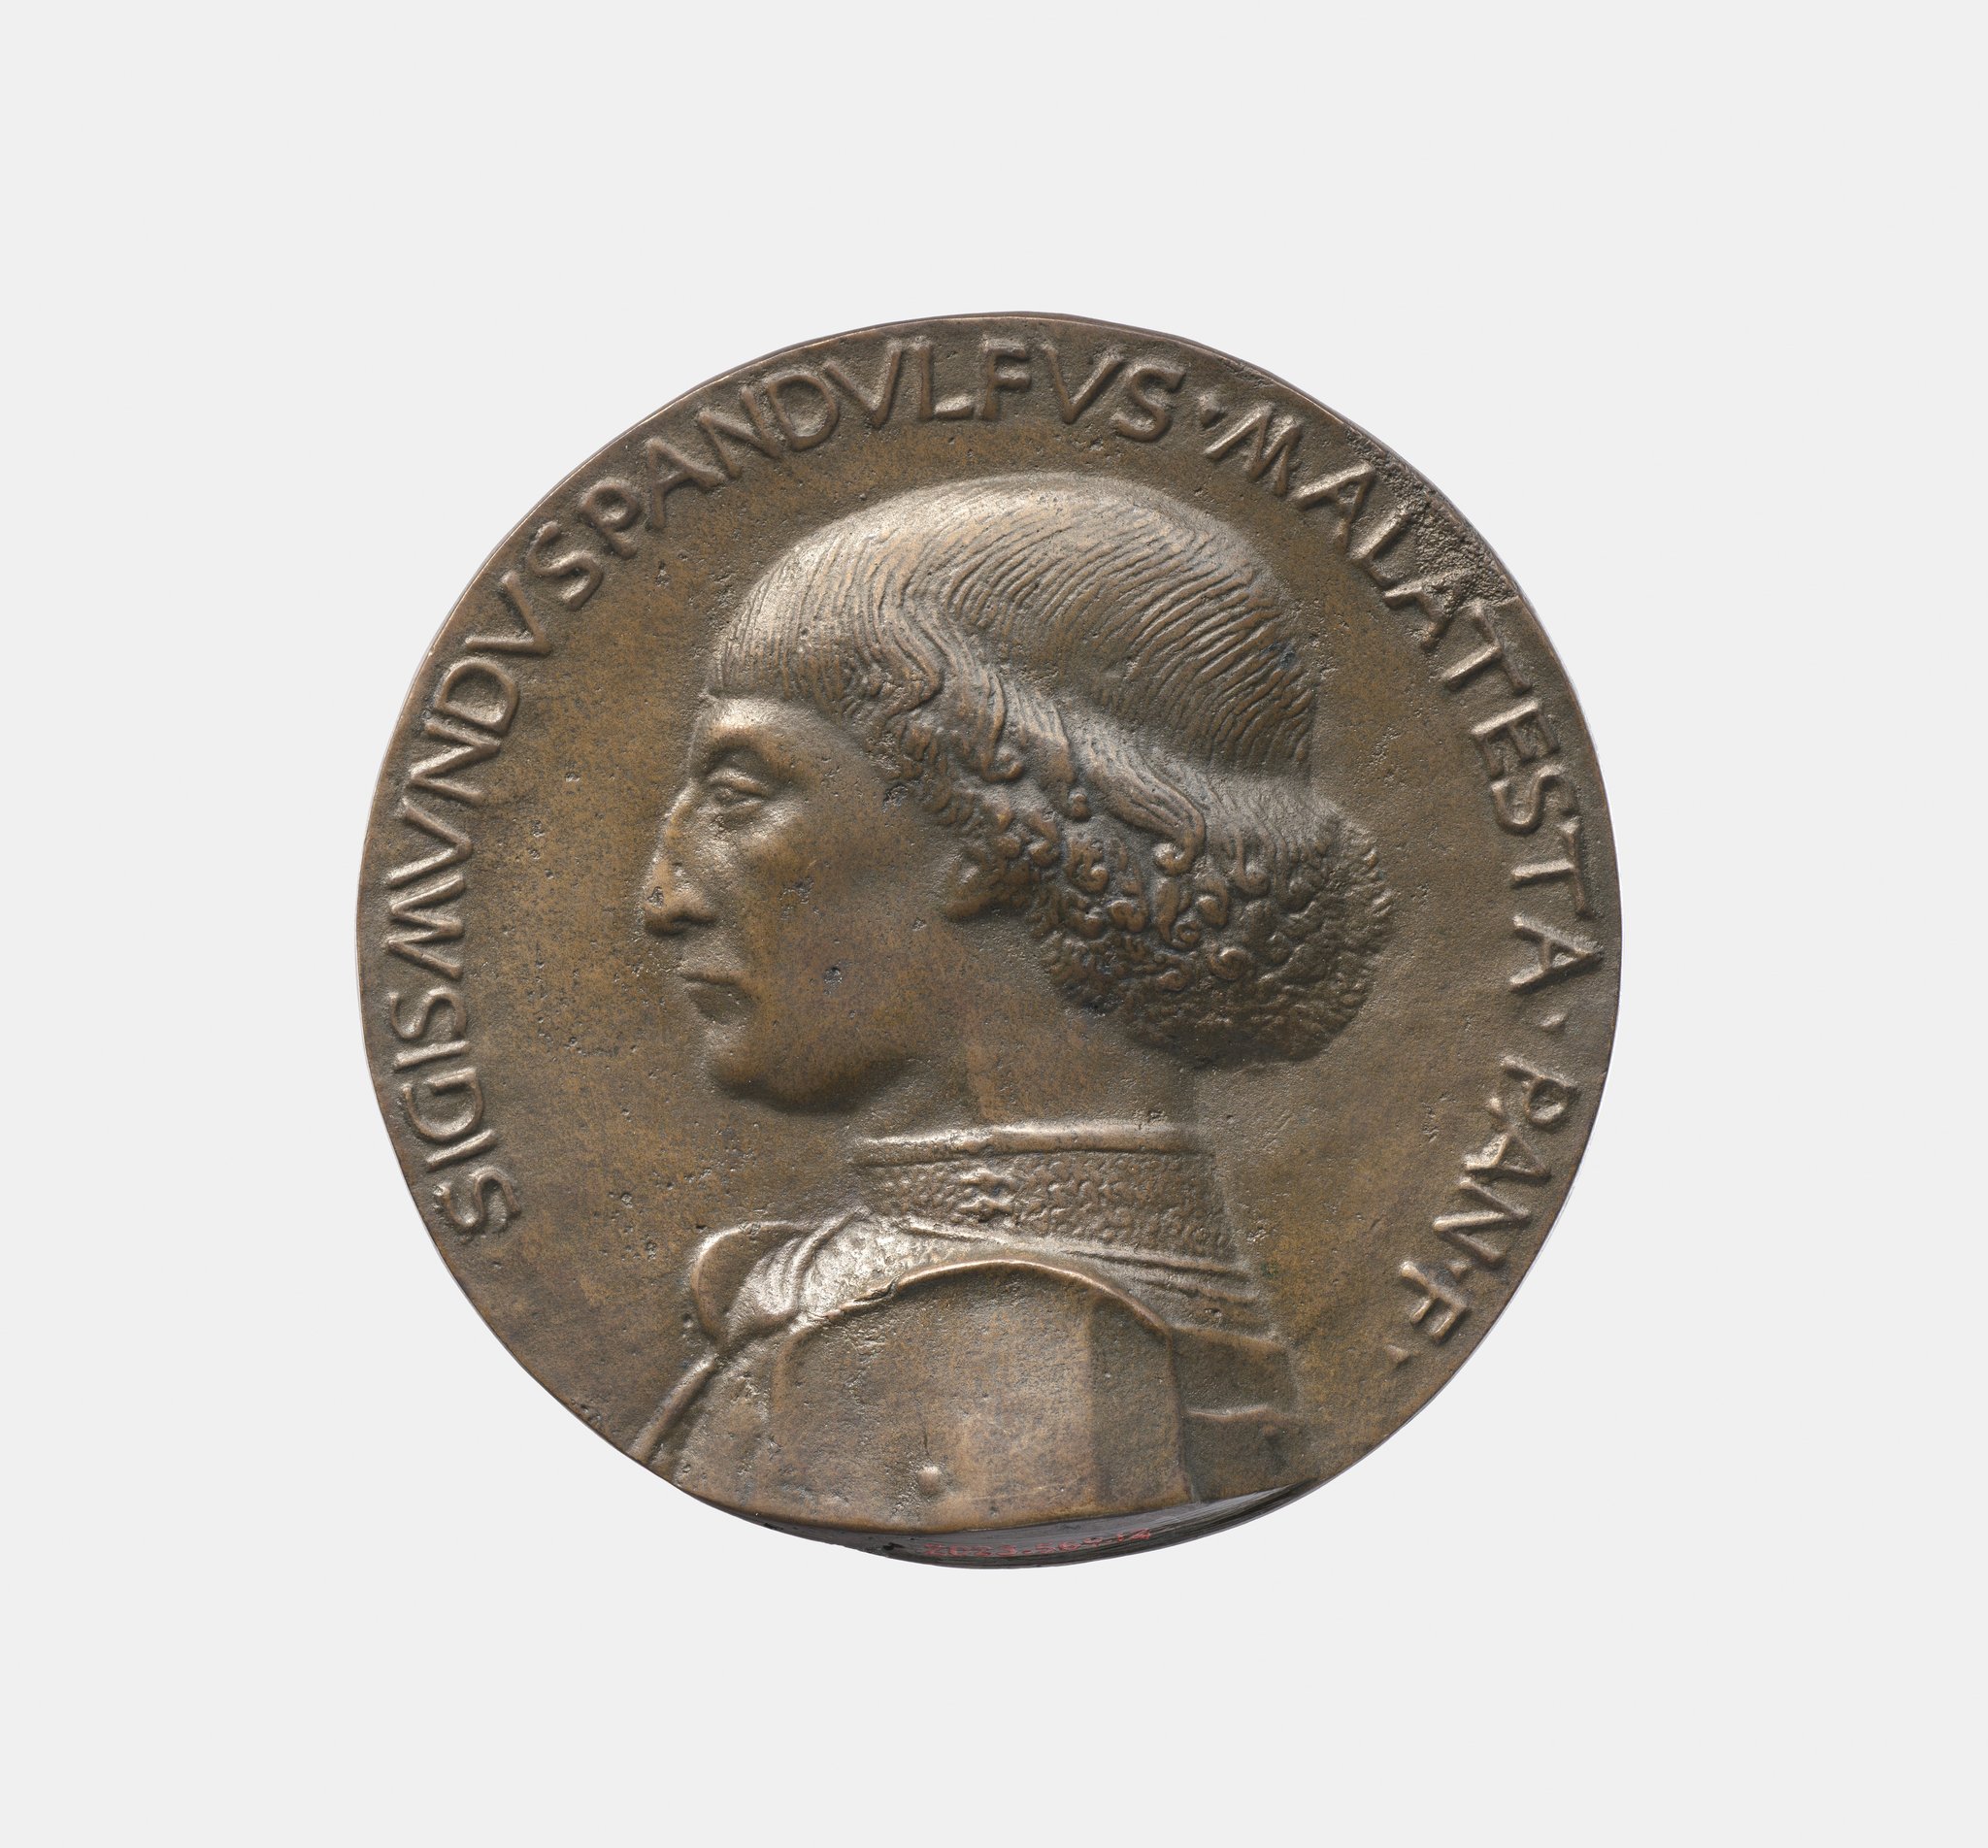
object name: medal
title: Sigismondo Pandolfo Malatesta, Lord of Rimini 1417–1468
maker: matteo de' pasti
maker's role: artist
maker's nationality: italian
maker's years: 1420-1467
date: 1446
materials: bronze